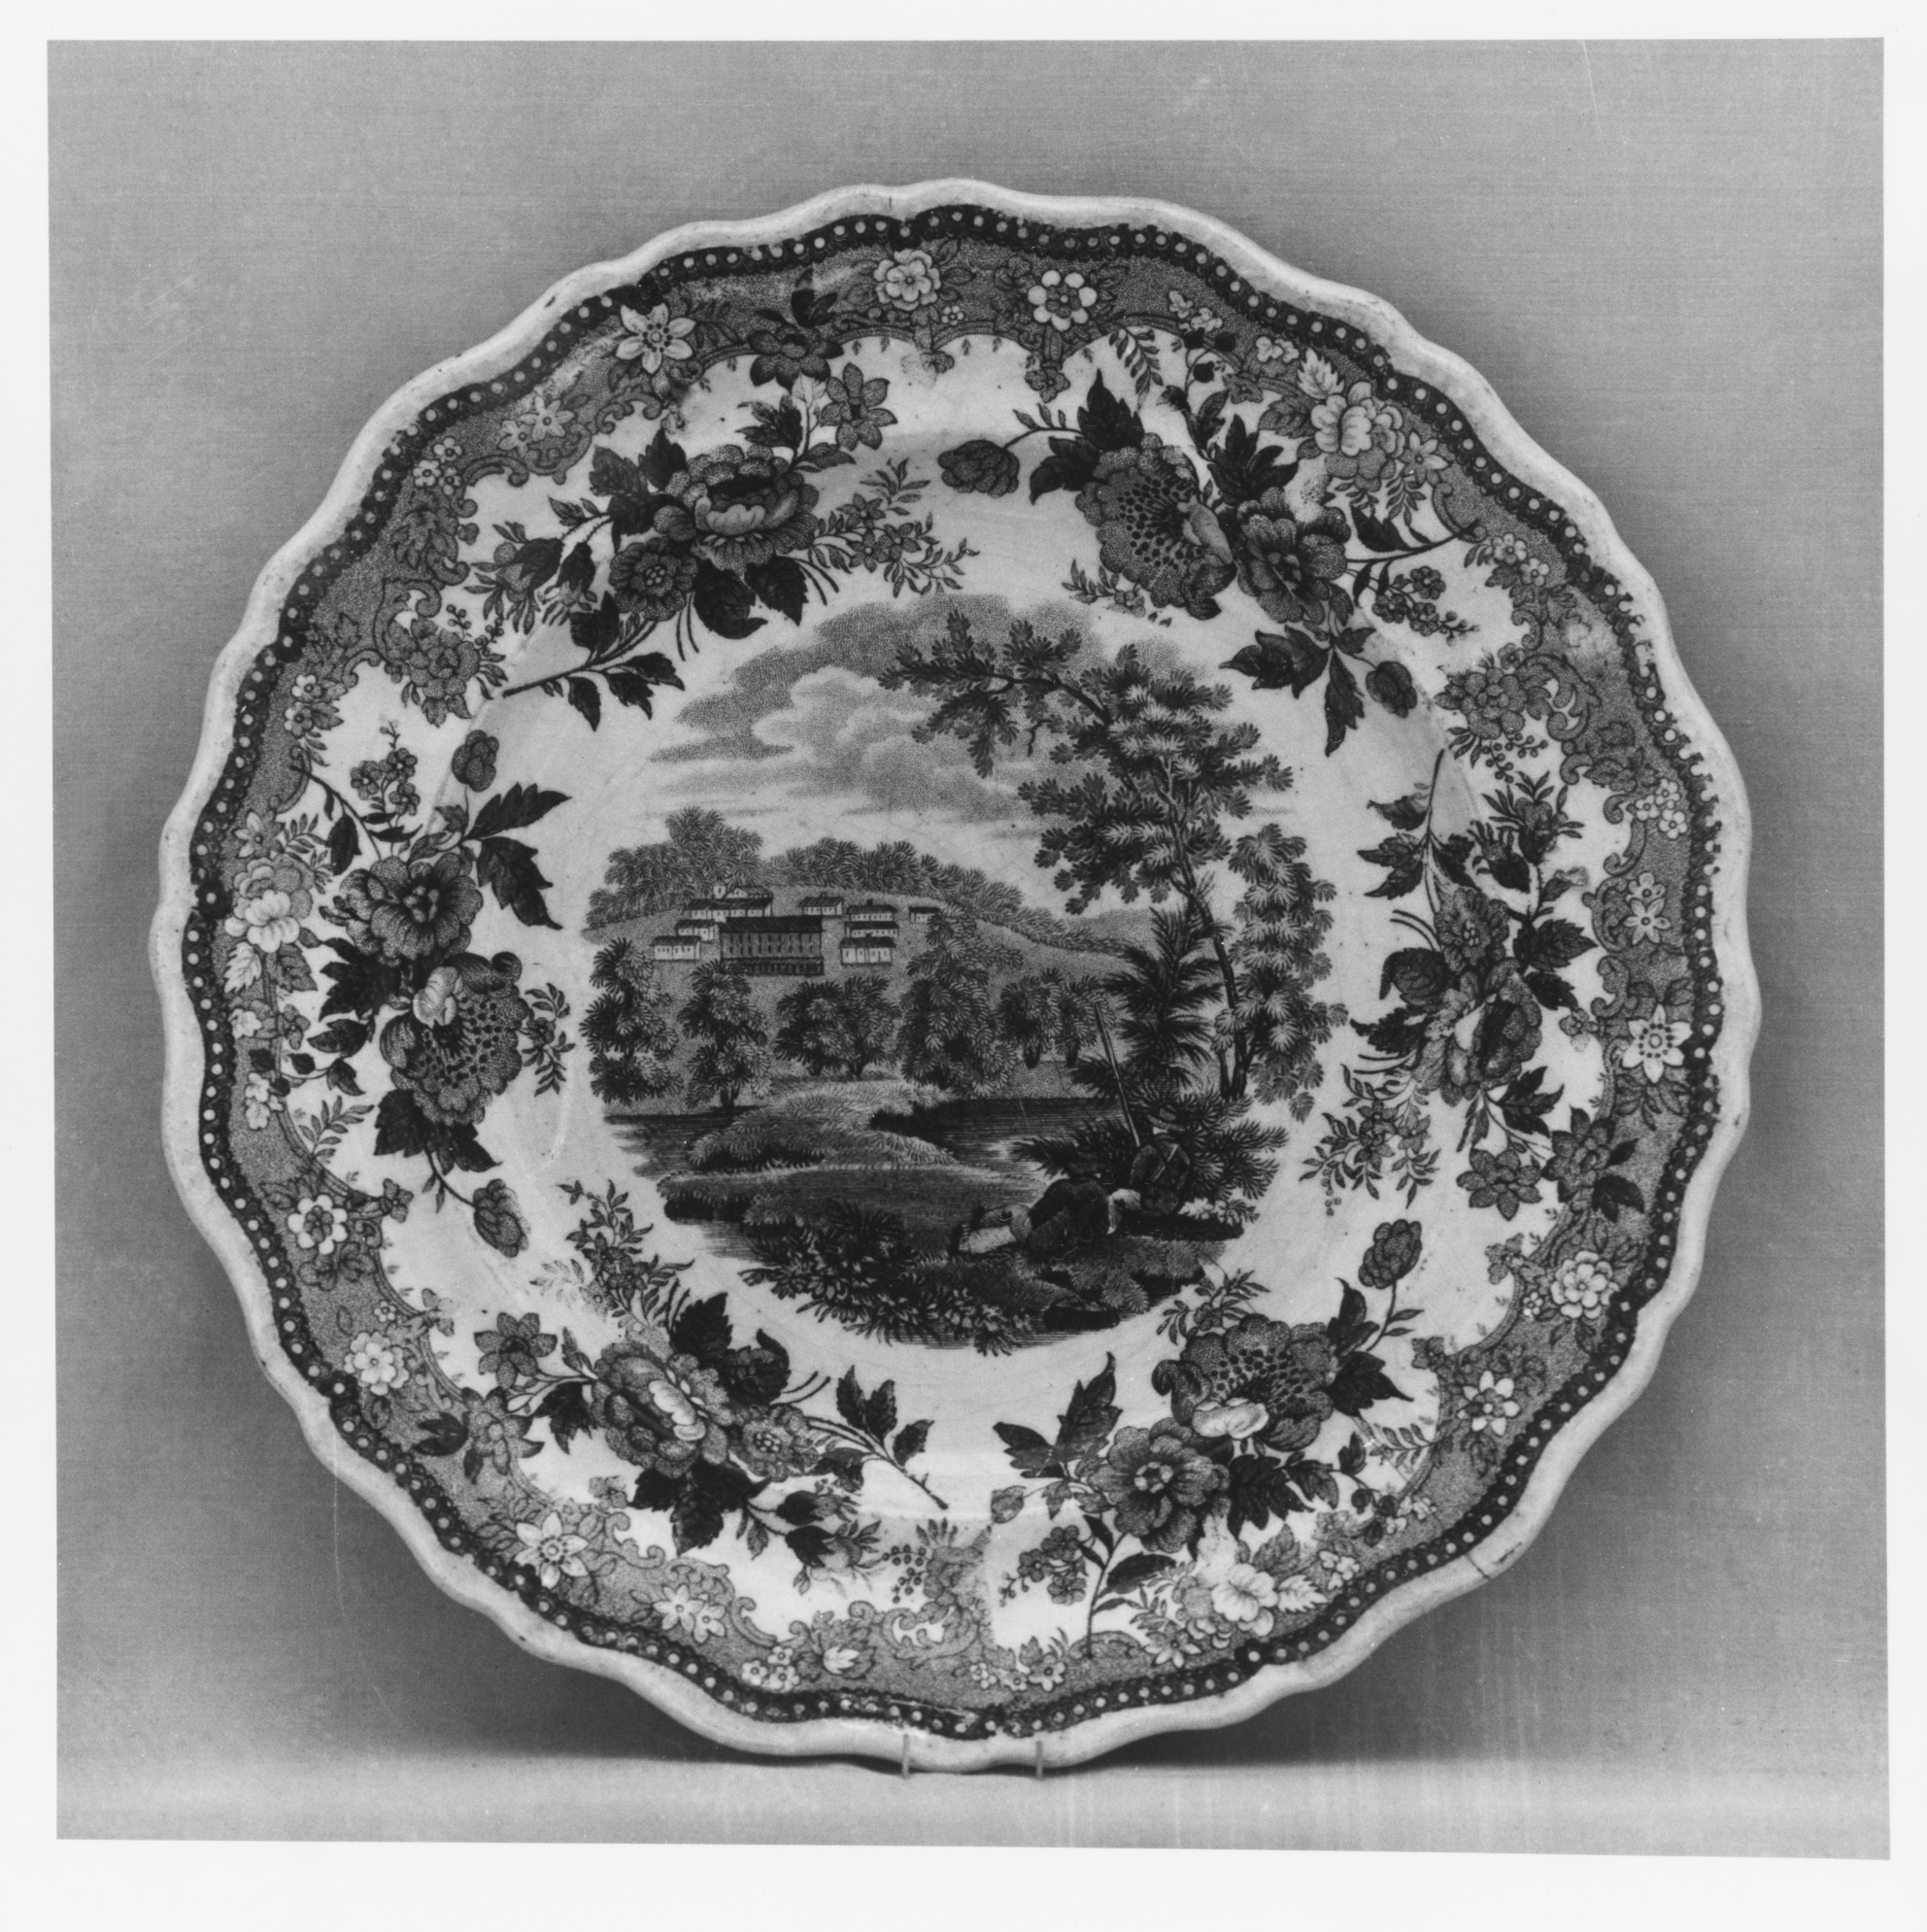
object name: plate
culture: british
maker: job & john jackson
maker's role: maker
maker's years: 1831-1835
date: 1831-1835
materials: earthenware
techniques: transfer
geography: england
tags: flowers,landscapes